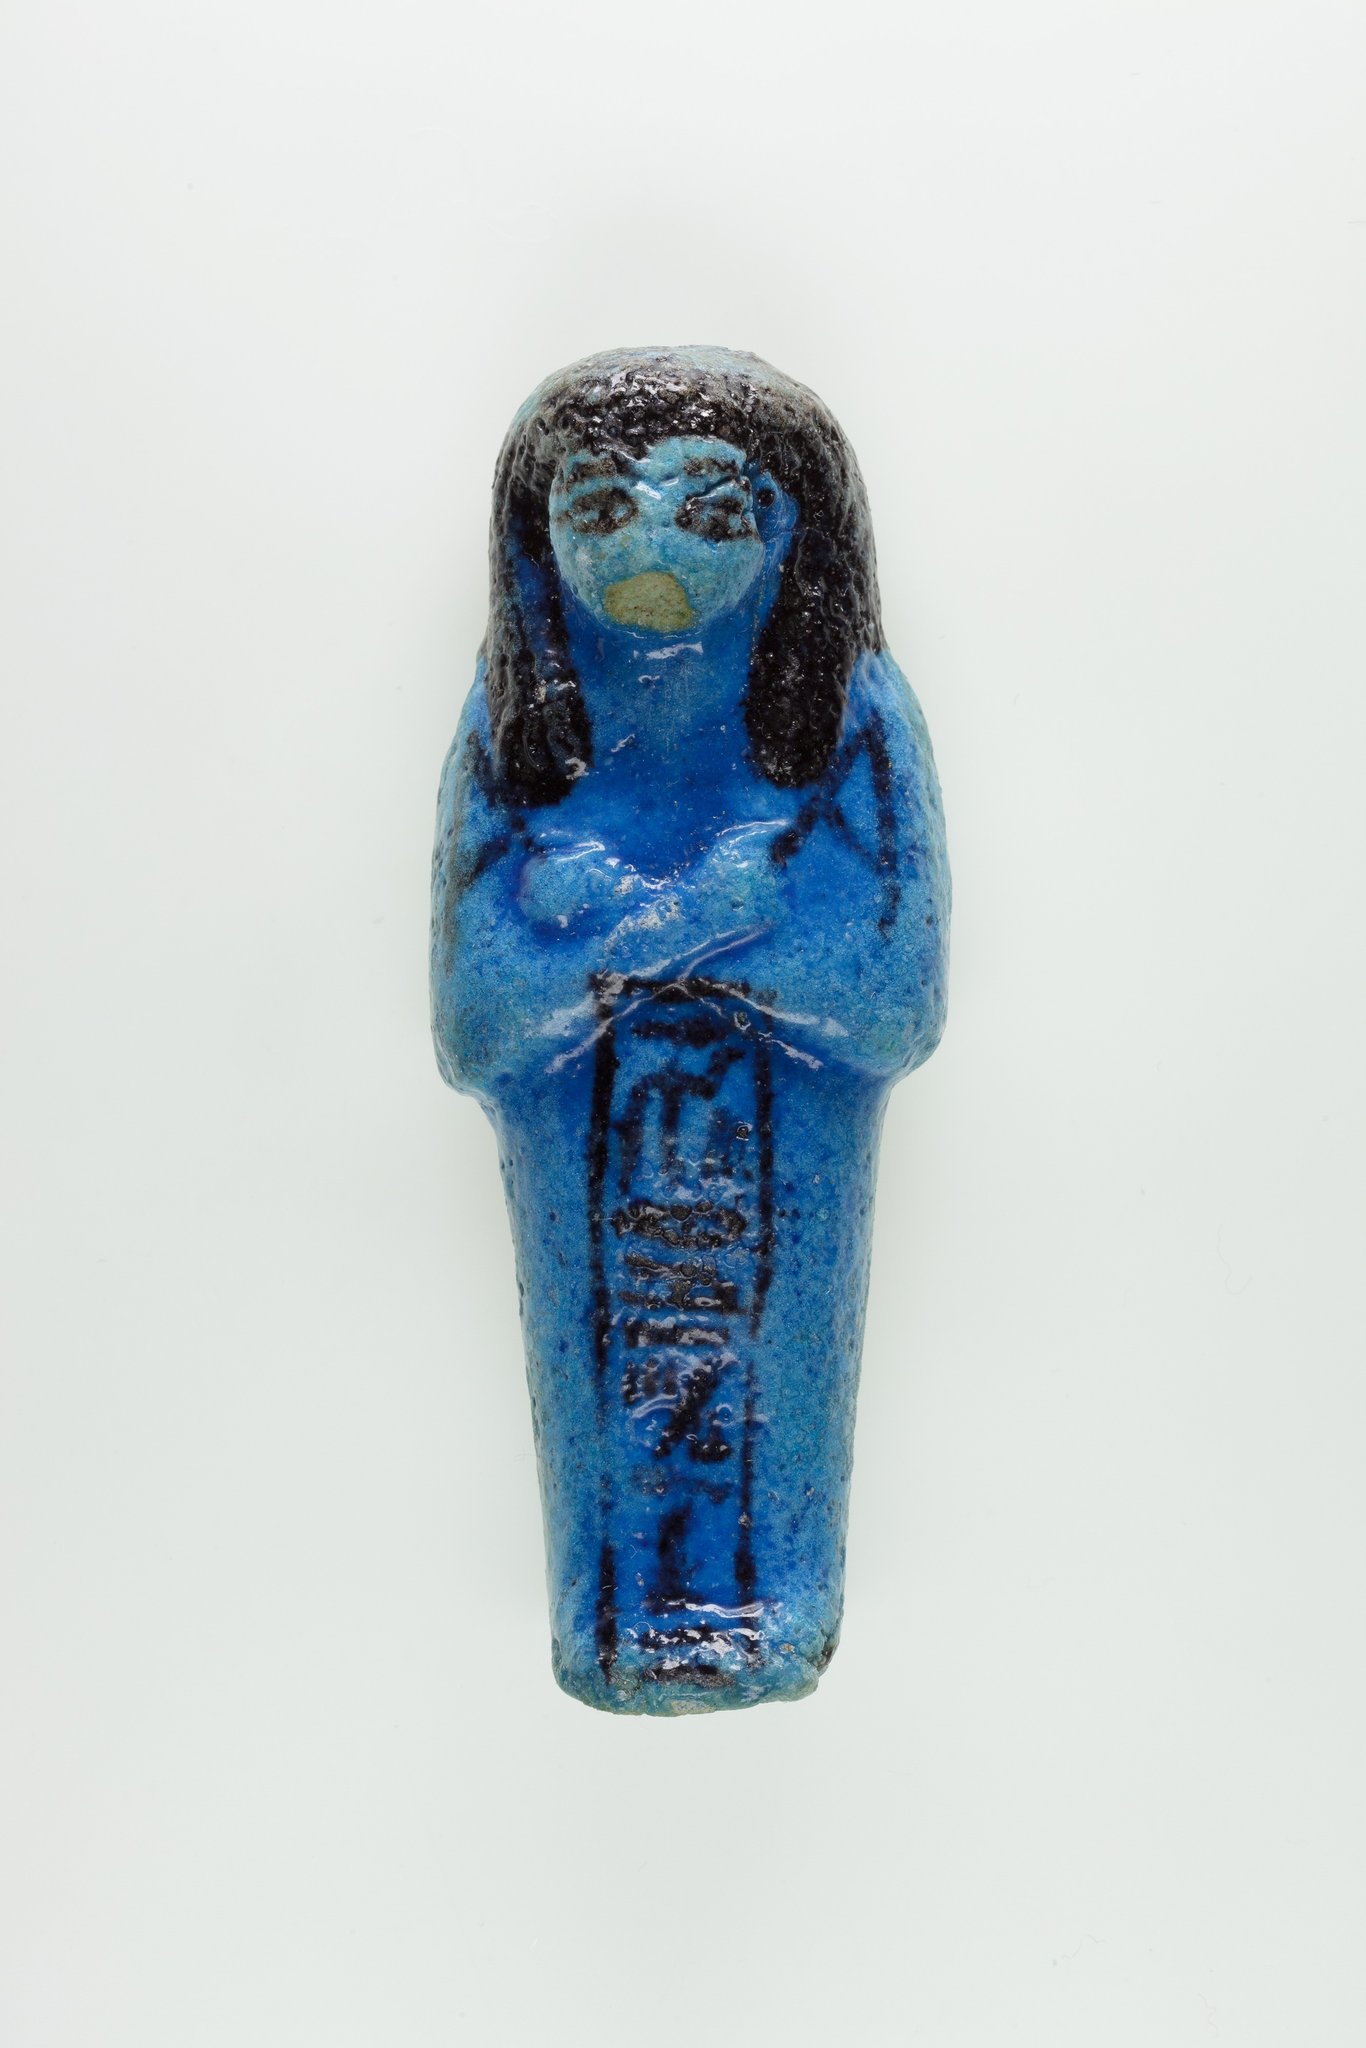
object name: shabti, worker, nauny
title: Worker Shabti of Nauny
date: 1050 BCE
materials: faience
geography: egypt